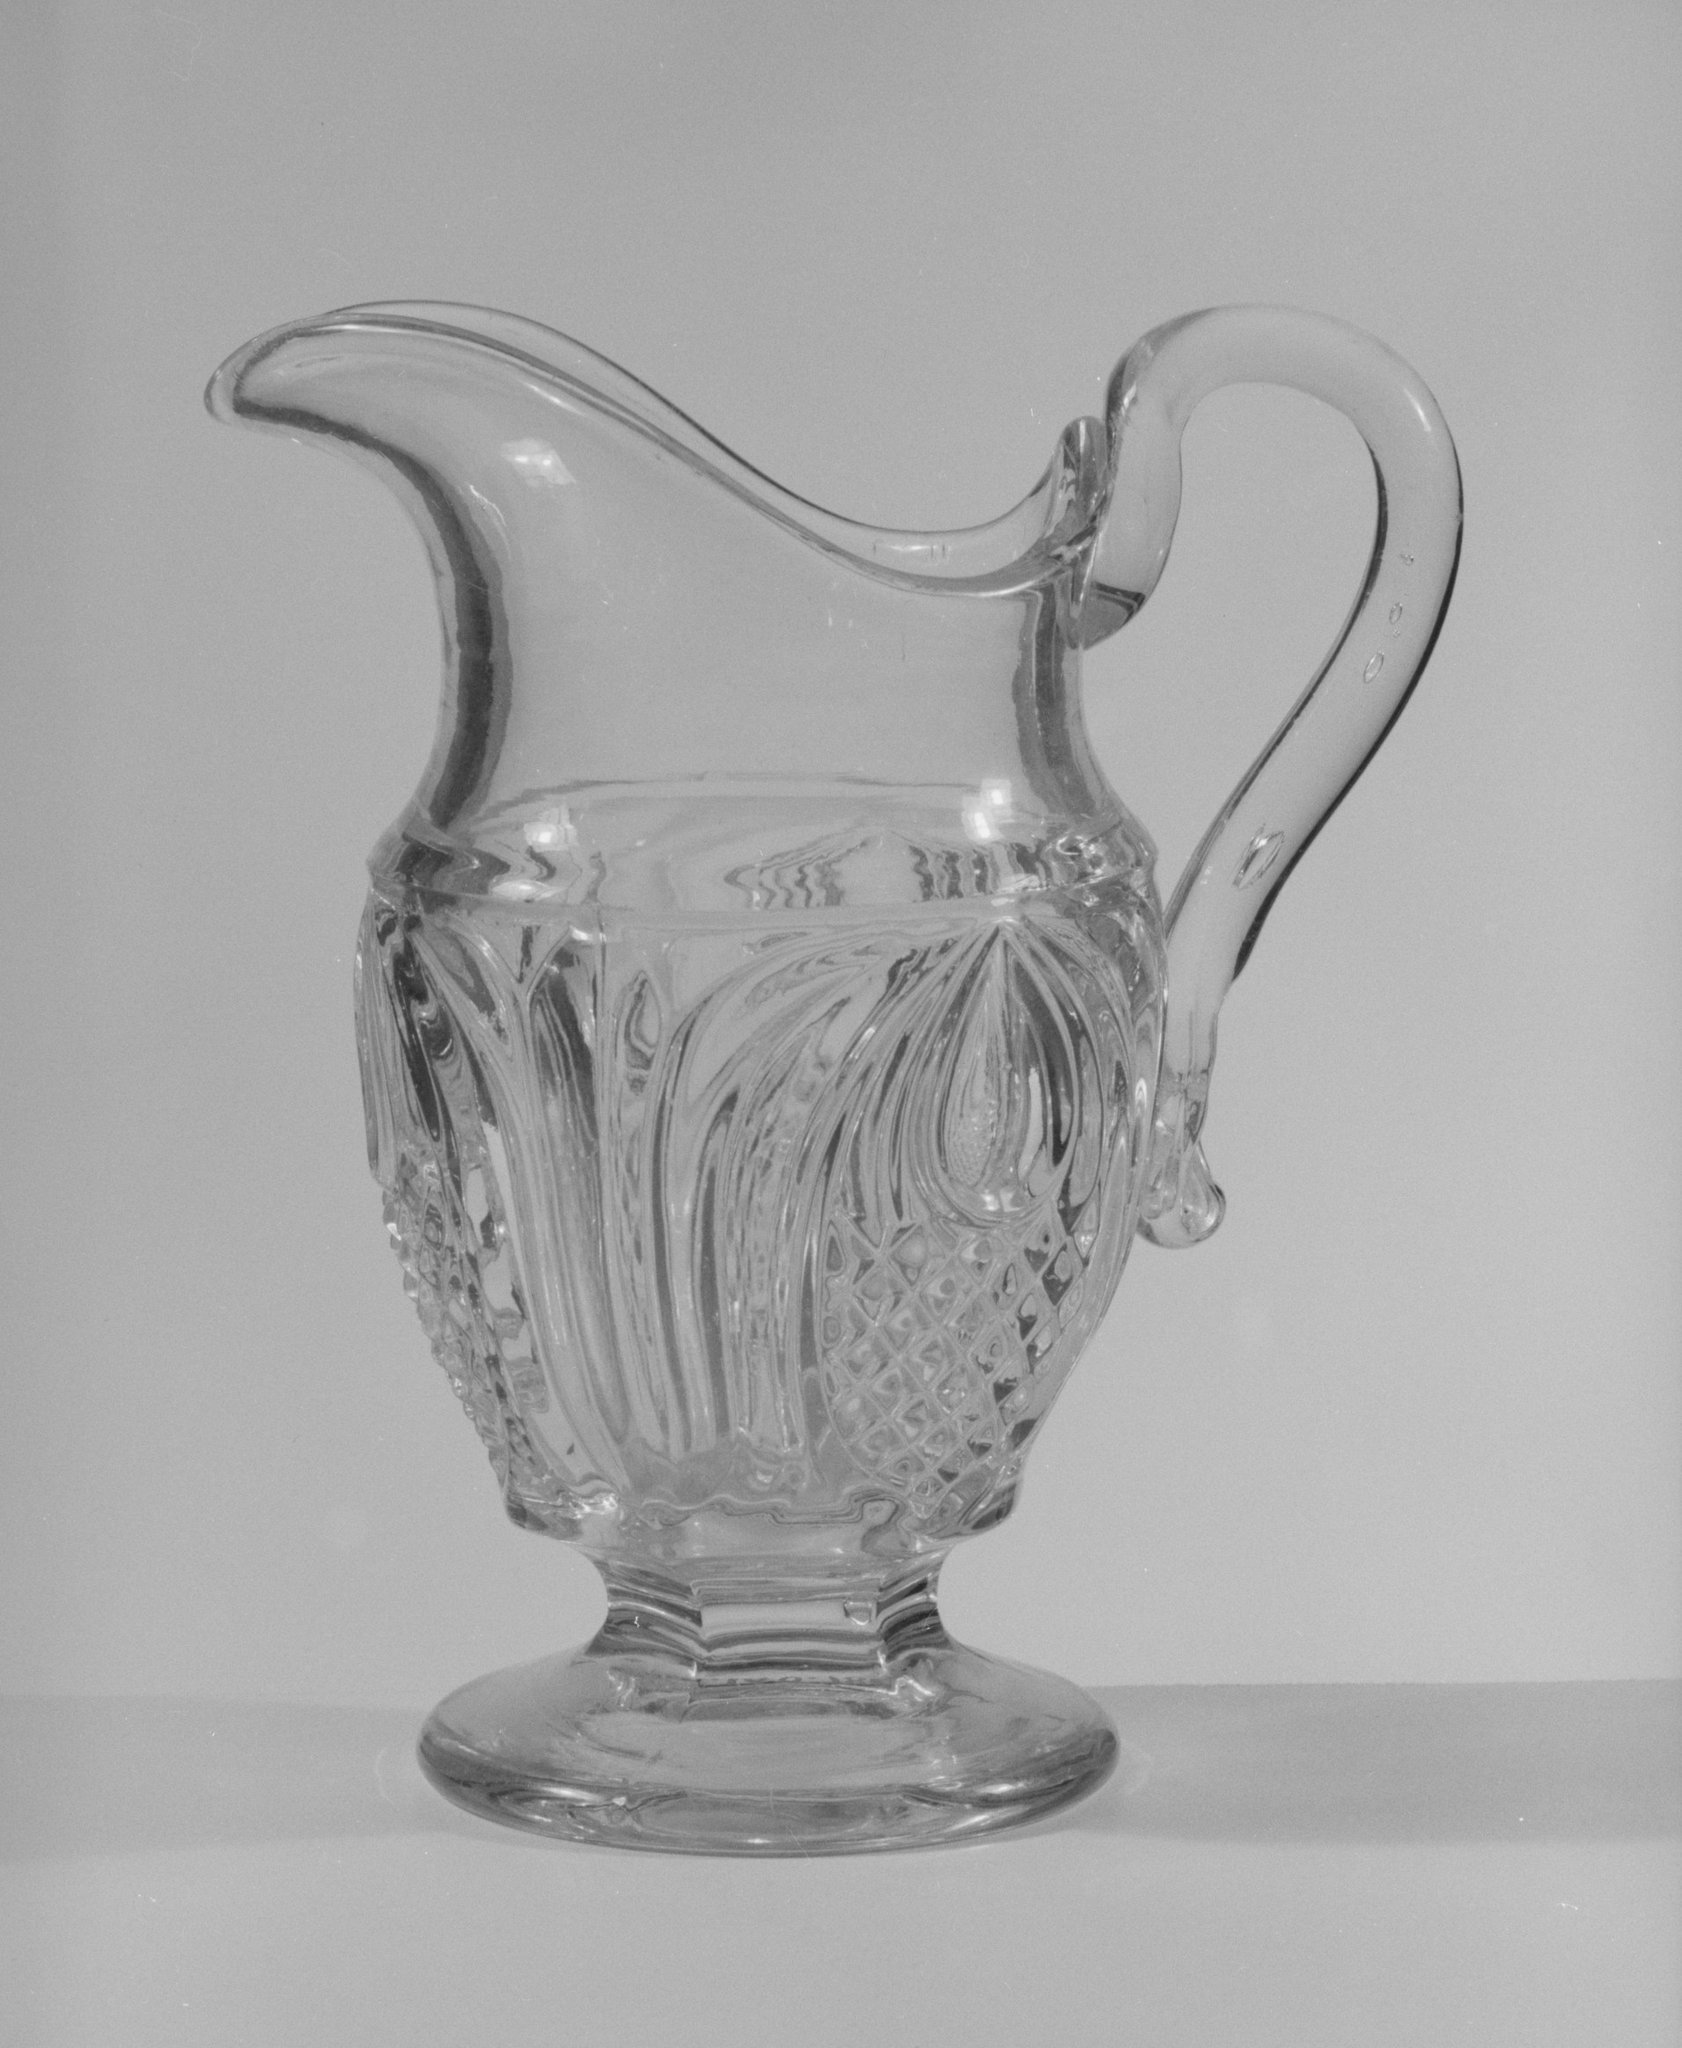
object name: pitcher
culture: american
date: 1850-1870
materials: glass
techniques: pressed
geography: united states